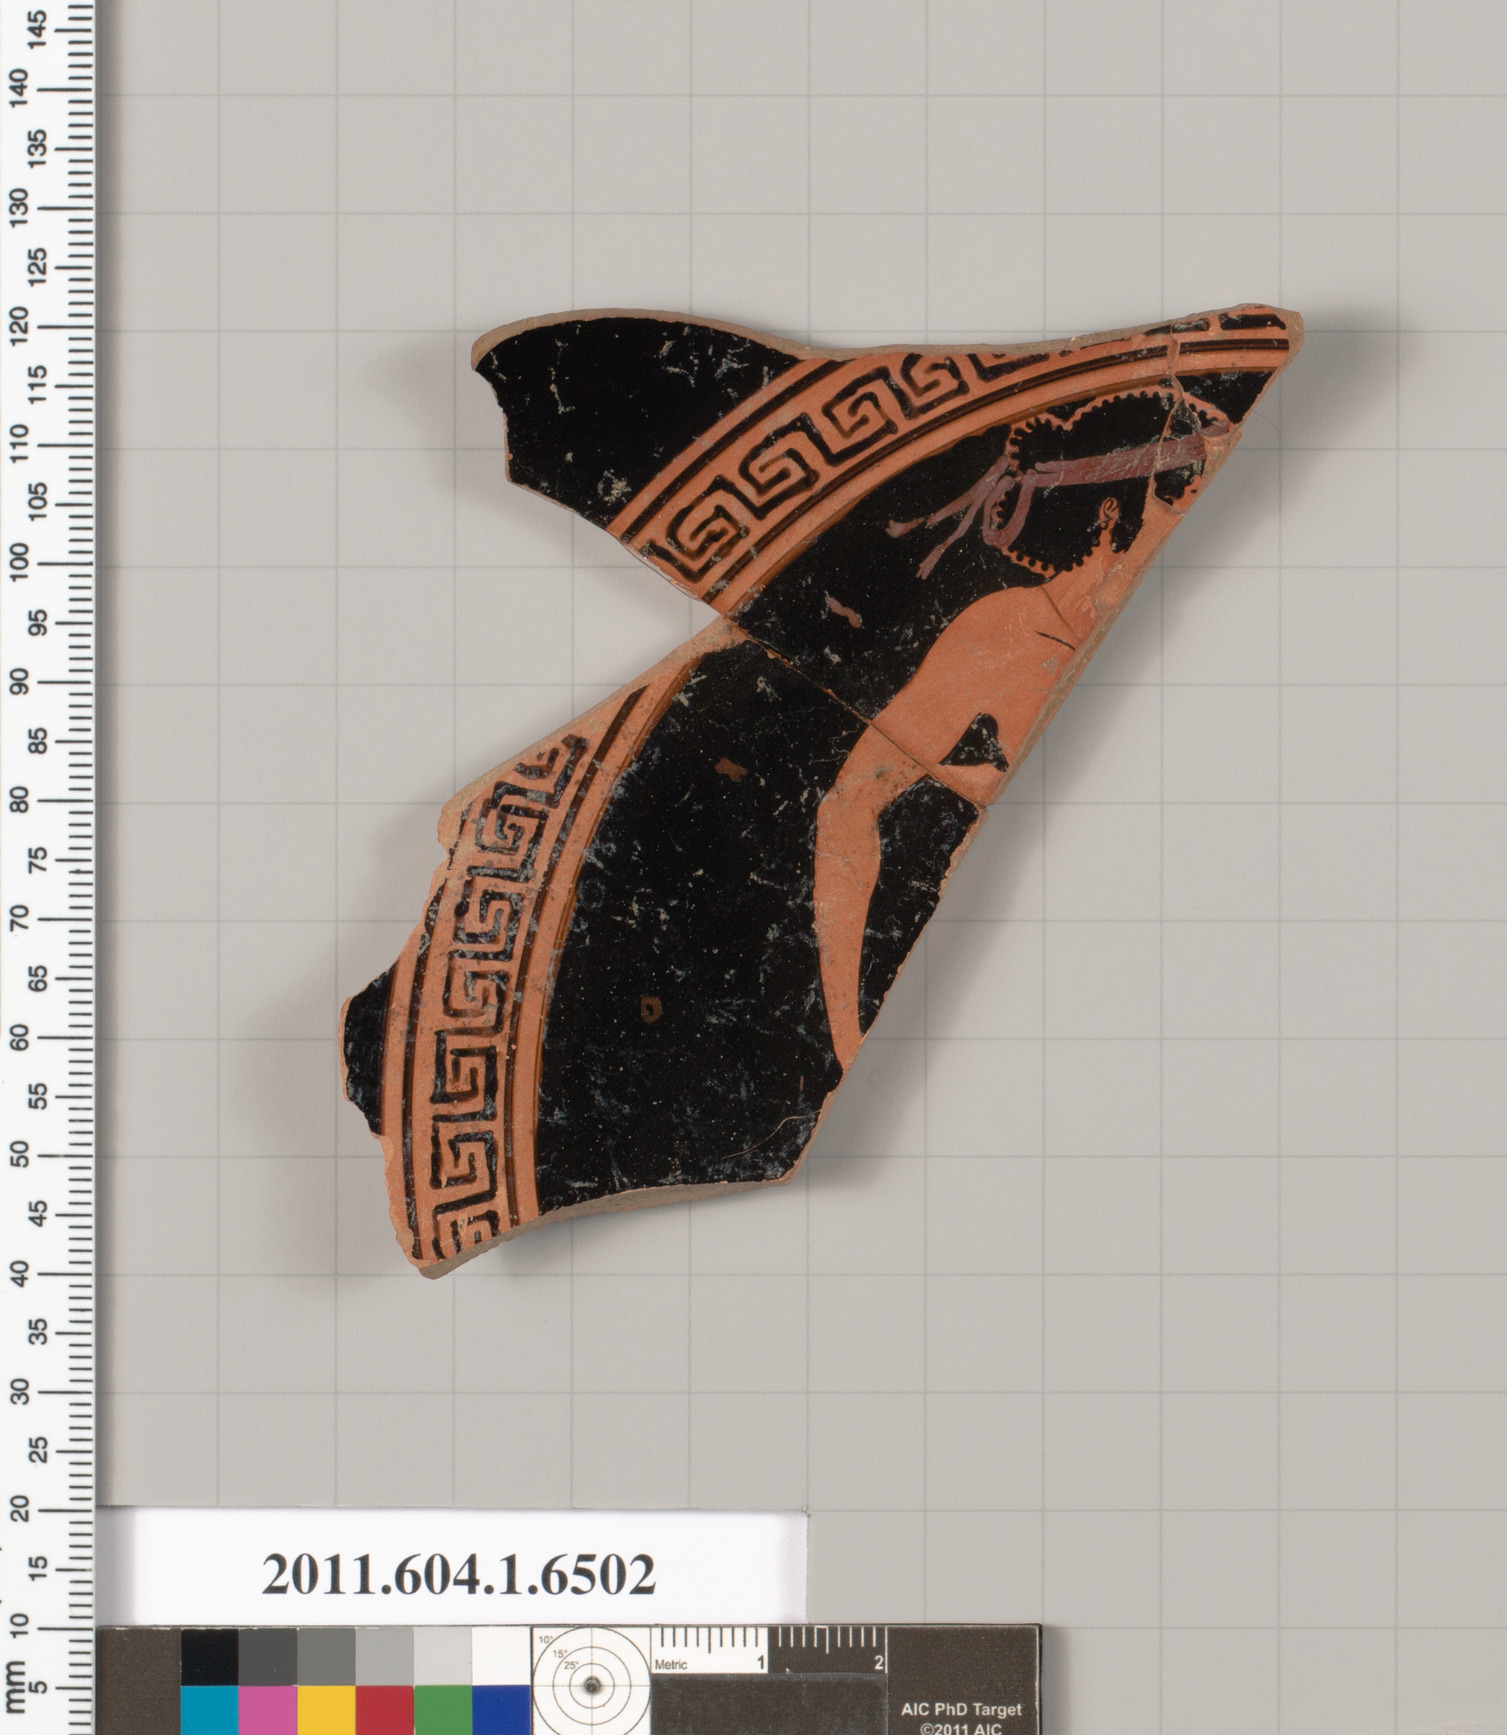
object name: kylix fragment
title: Terracotta fragment of a kylix (drinking cup)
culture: greek, attic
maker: colmar painter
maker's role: artist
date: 490-480 BCE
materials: terracotta